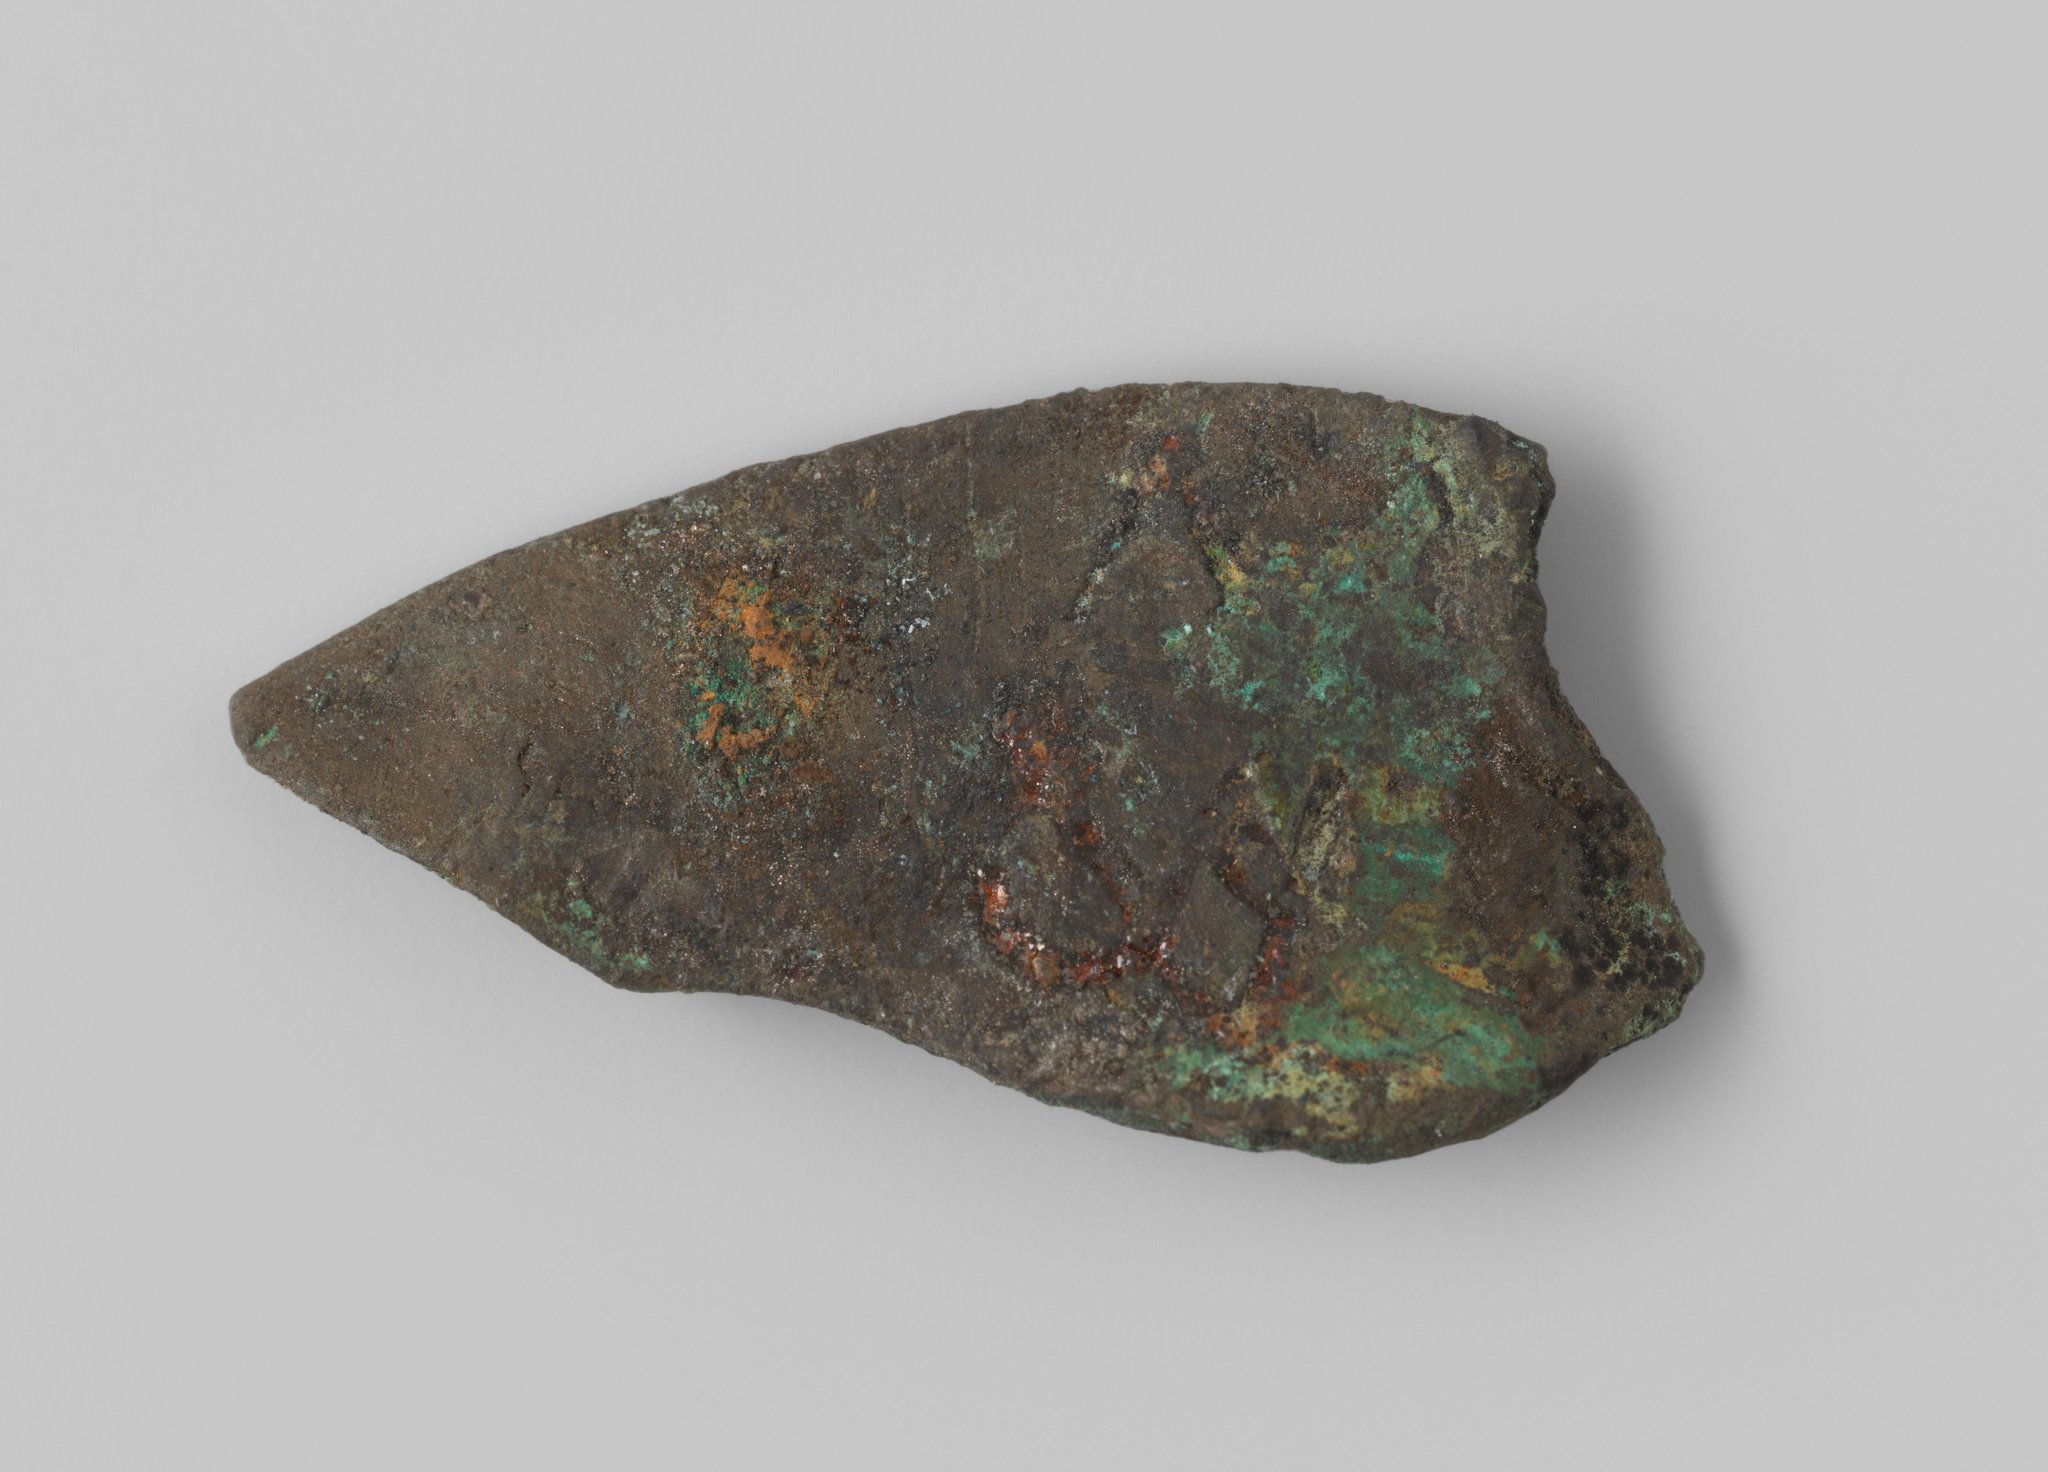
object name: musket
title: Fragment schroefplaat van een musket uit het wrak van de Oost-Indiëvaarder Hollandia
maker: Anonymous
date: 1700-1743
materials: copper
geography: netherlands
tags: verenigde oostindische compagnie, hollandia (schip), annet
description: Fragm of left wing, id. NG 1980-27H3069, side plate.